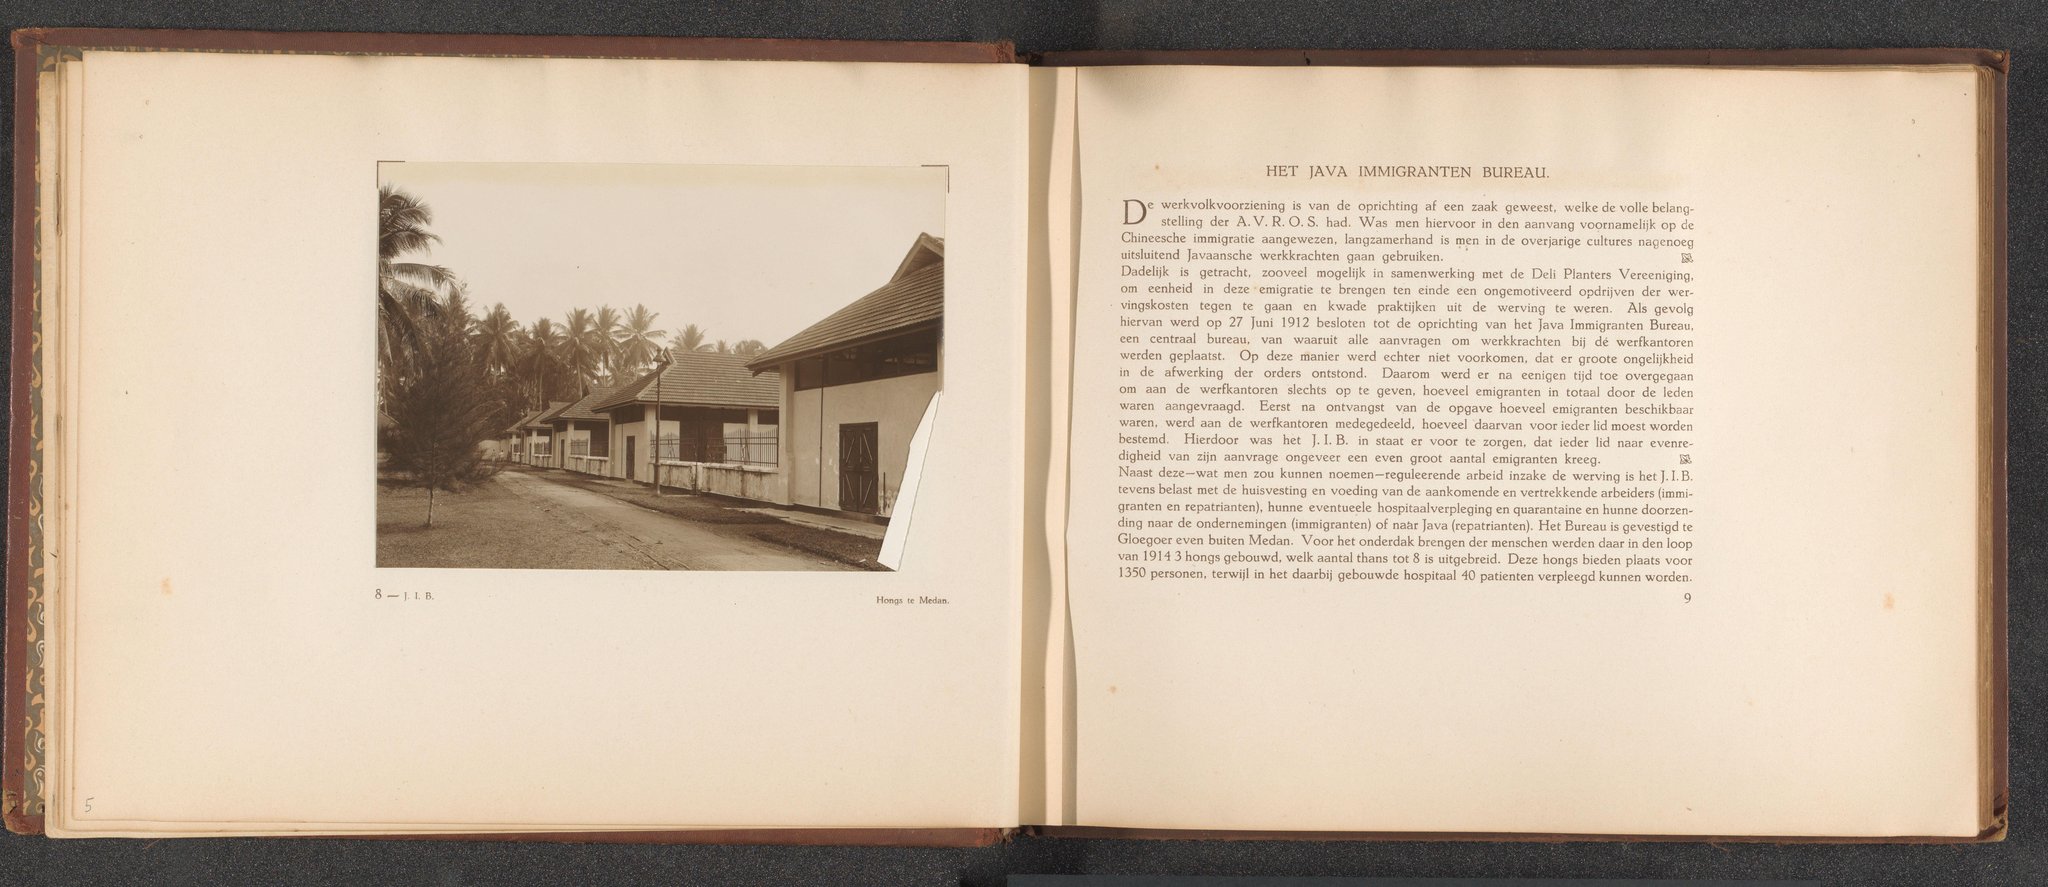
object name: photograph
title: Pagina 8 en 9 van fotoboek van de Algemeene Vereeniging van Rubberplanters ter Oostkust van Sumatra (A.V.R.O.S.)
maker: j.w. meyster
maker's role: fotograaf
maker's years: 1887-1945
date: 1924-1925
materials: paper, photographic support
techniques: printing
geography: sumatra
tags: (non-fruit) products of plants or trees: rubber, barracks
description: Twee boekpagina's met links een foto van barakken voor werkkrachten ('hongs') te Medan en rechts informatie over het Java Immigranten Bureau (J.I.B.). Onderdeel van een fotoboek van de Algemeene Vereeniging van Rubberplanters ter Oostkust van Sumatra (A.V.R.O.S.).